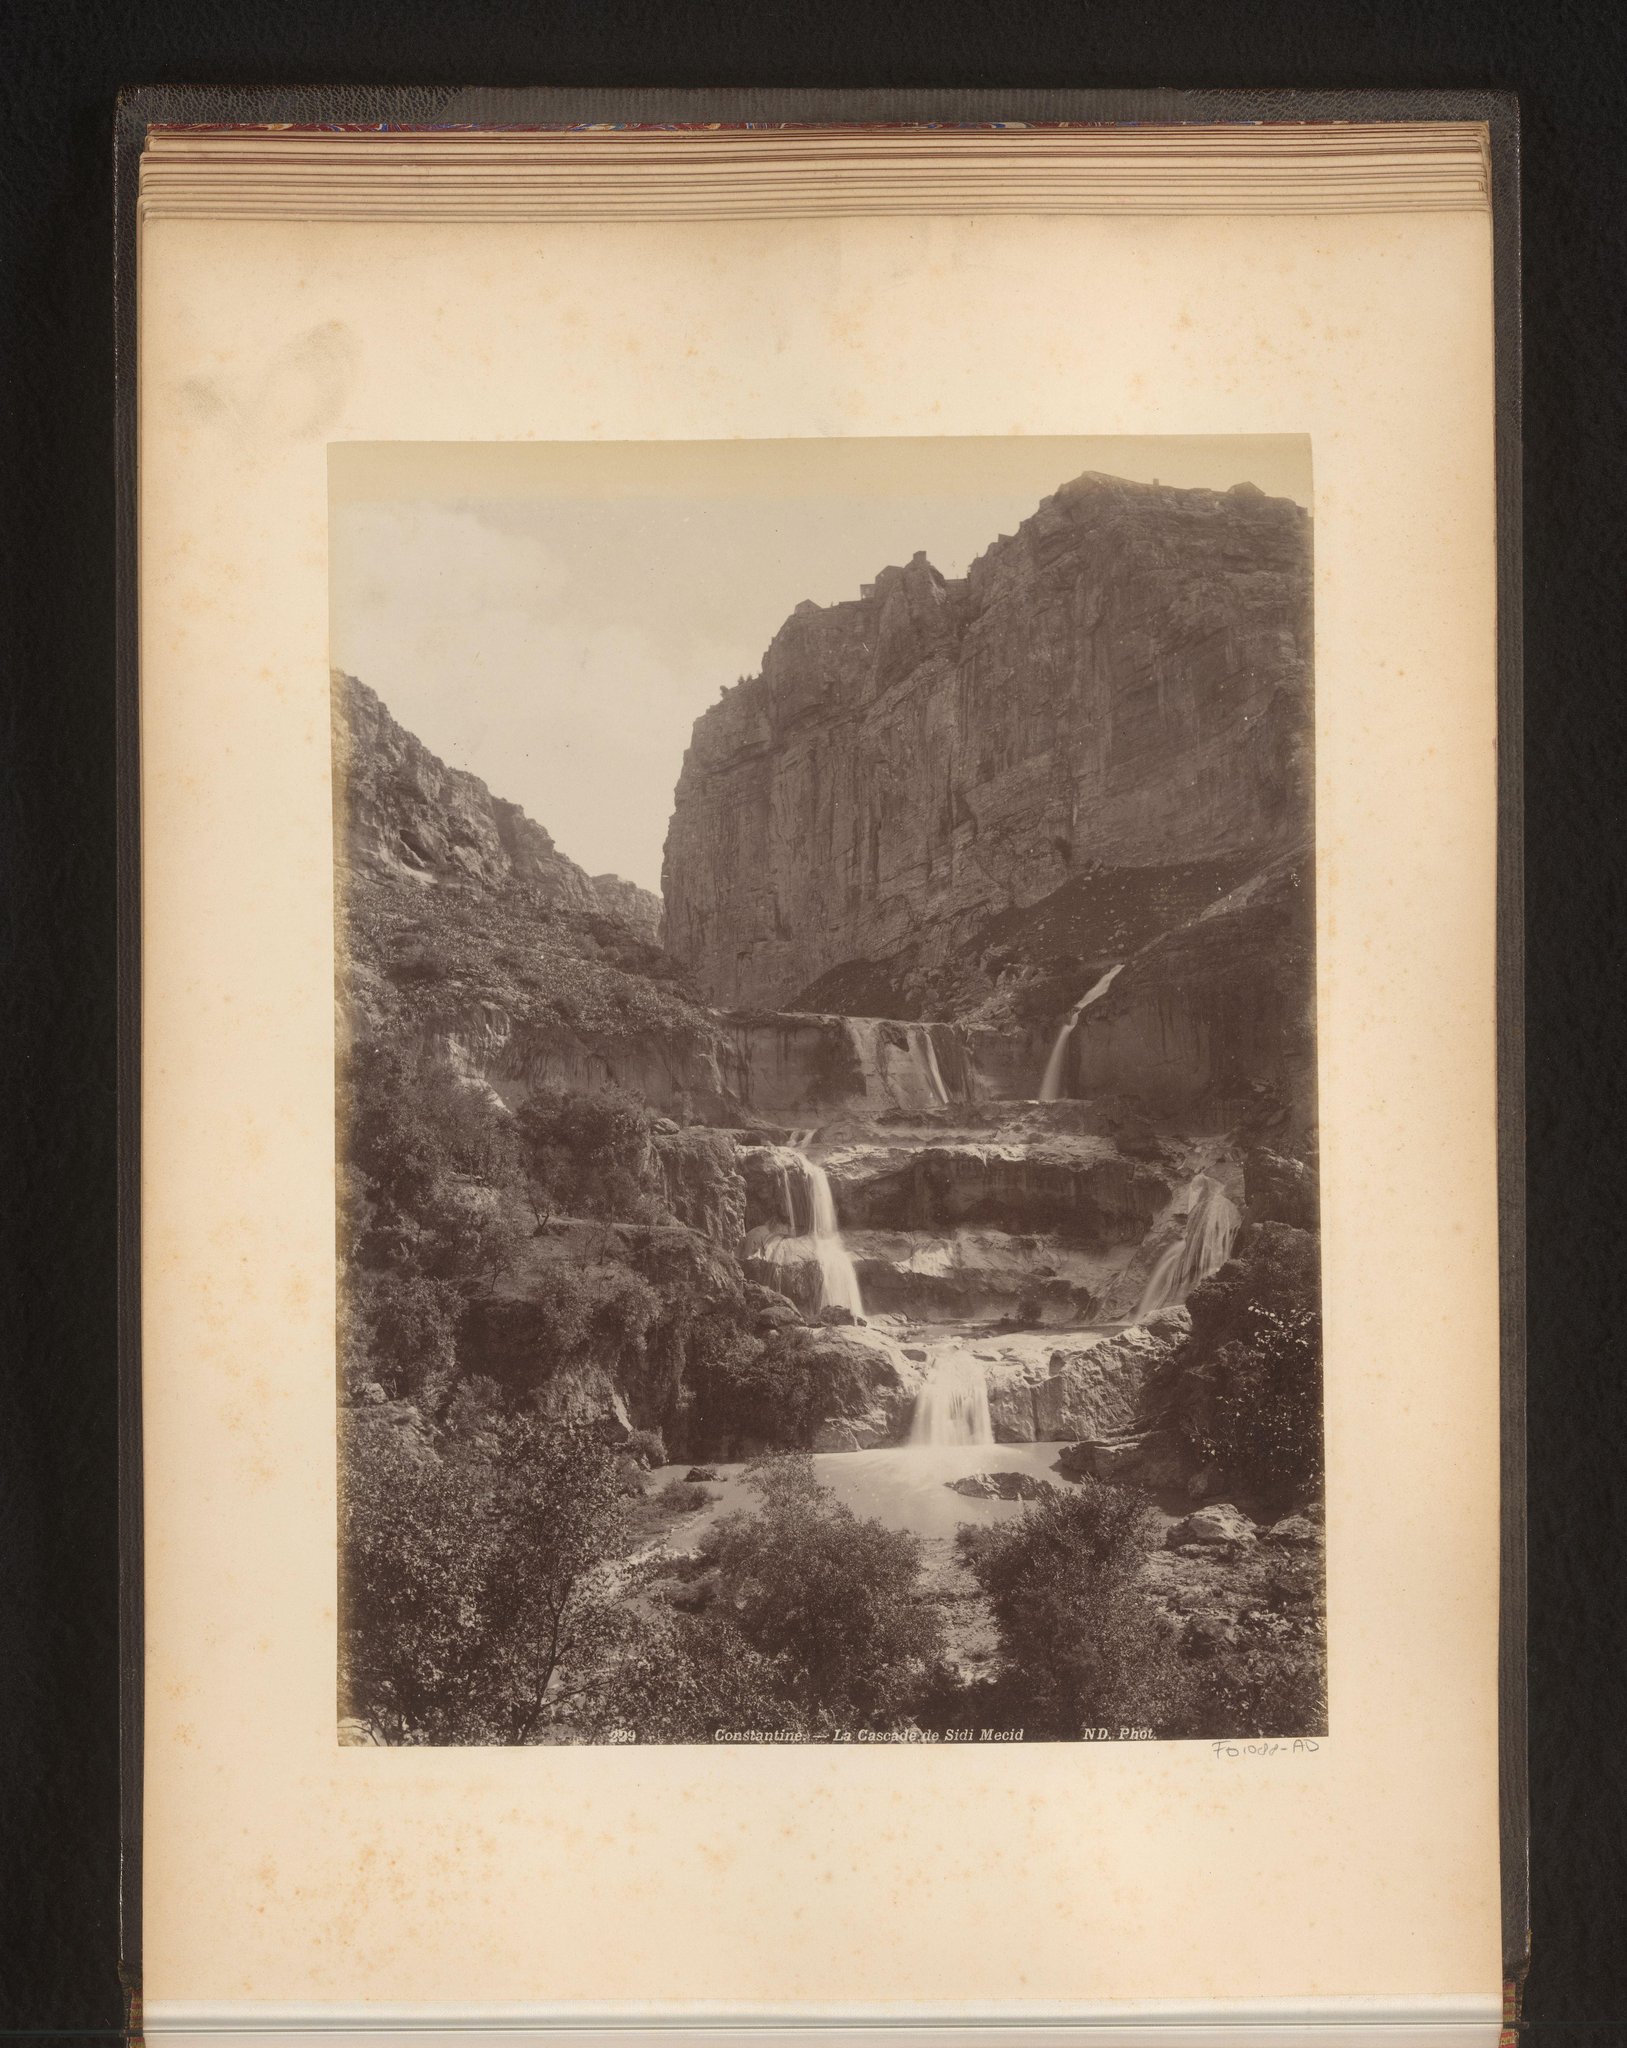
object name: album leaf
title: Gezicht op de Sidi Mecid waterval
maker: étienne neurdein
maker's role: publisher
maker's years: 1832-1918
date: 1880-1900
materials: photographic support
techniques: albumen print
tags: waterfall, rocks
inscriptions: number: ‘229’